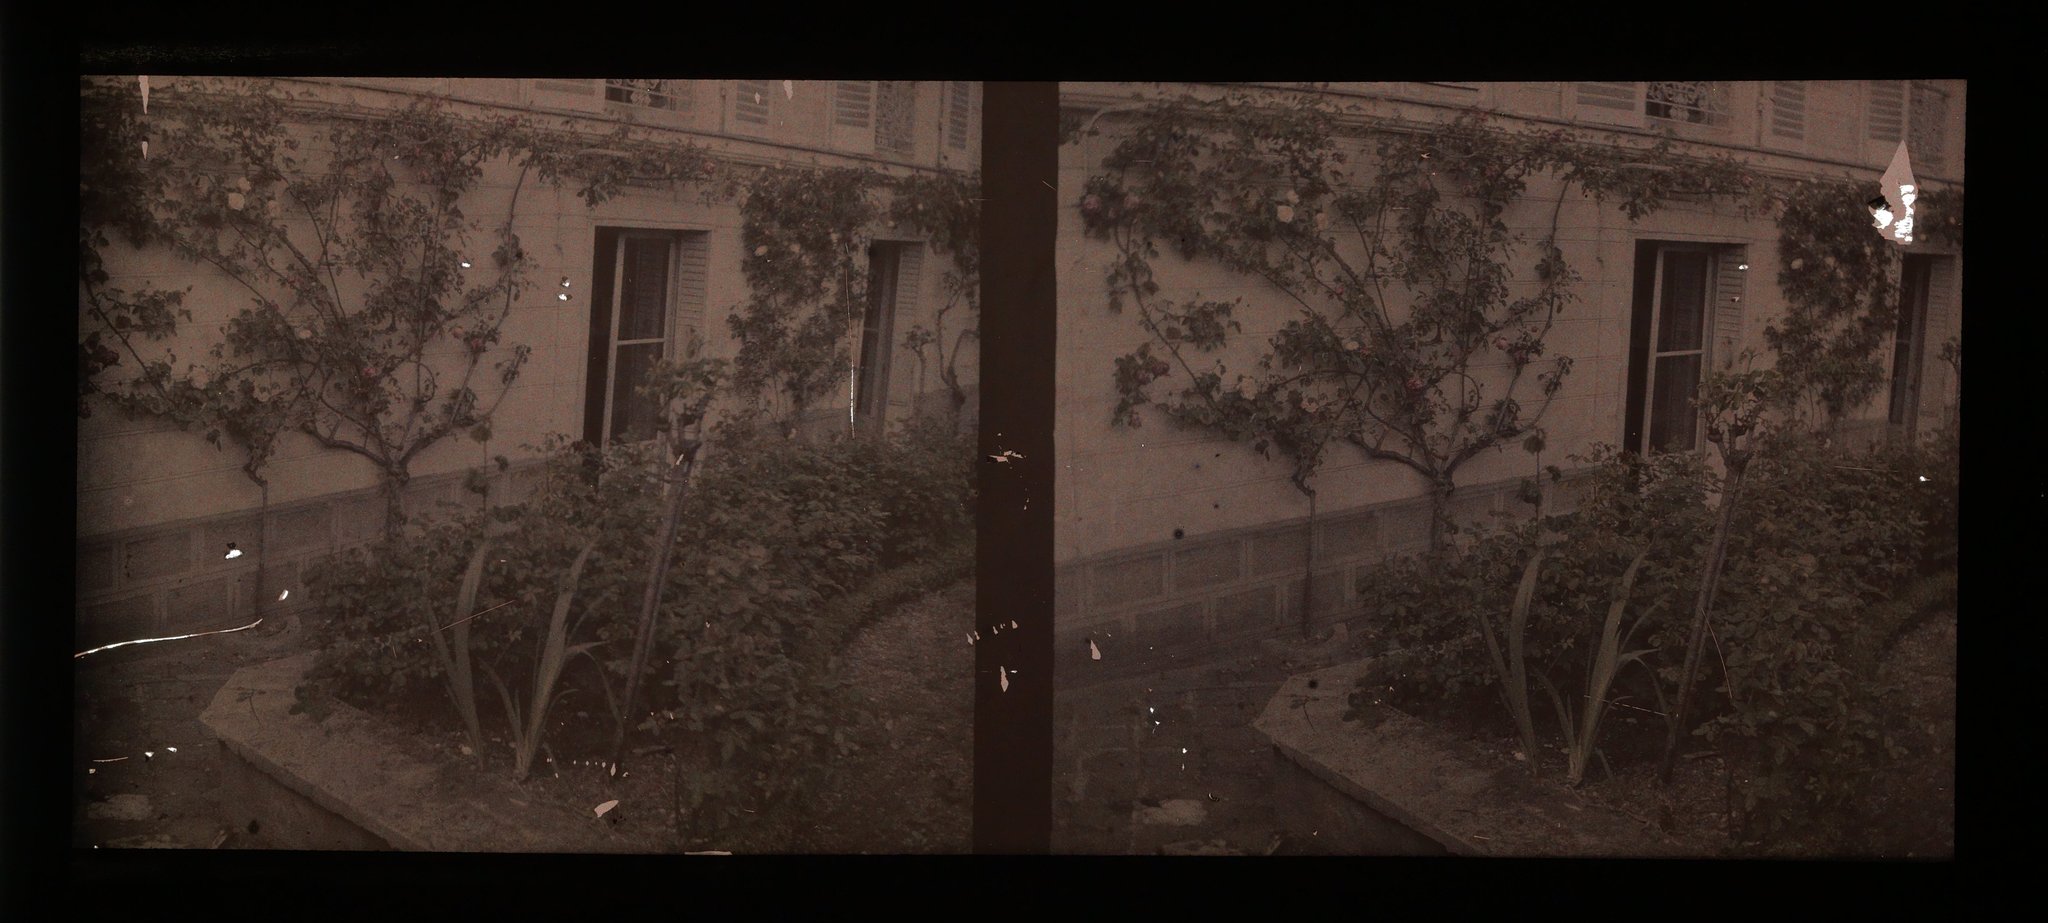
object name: stereograph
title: Tuin bij een huis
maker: Anonymous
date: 1910-1940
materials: glass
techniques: autochrome process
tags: garden